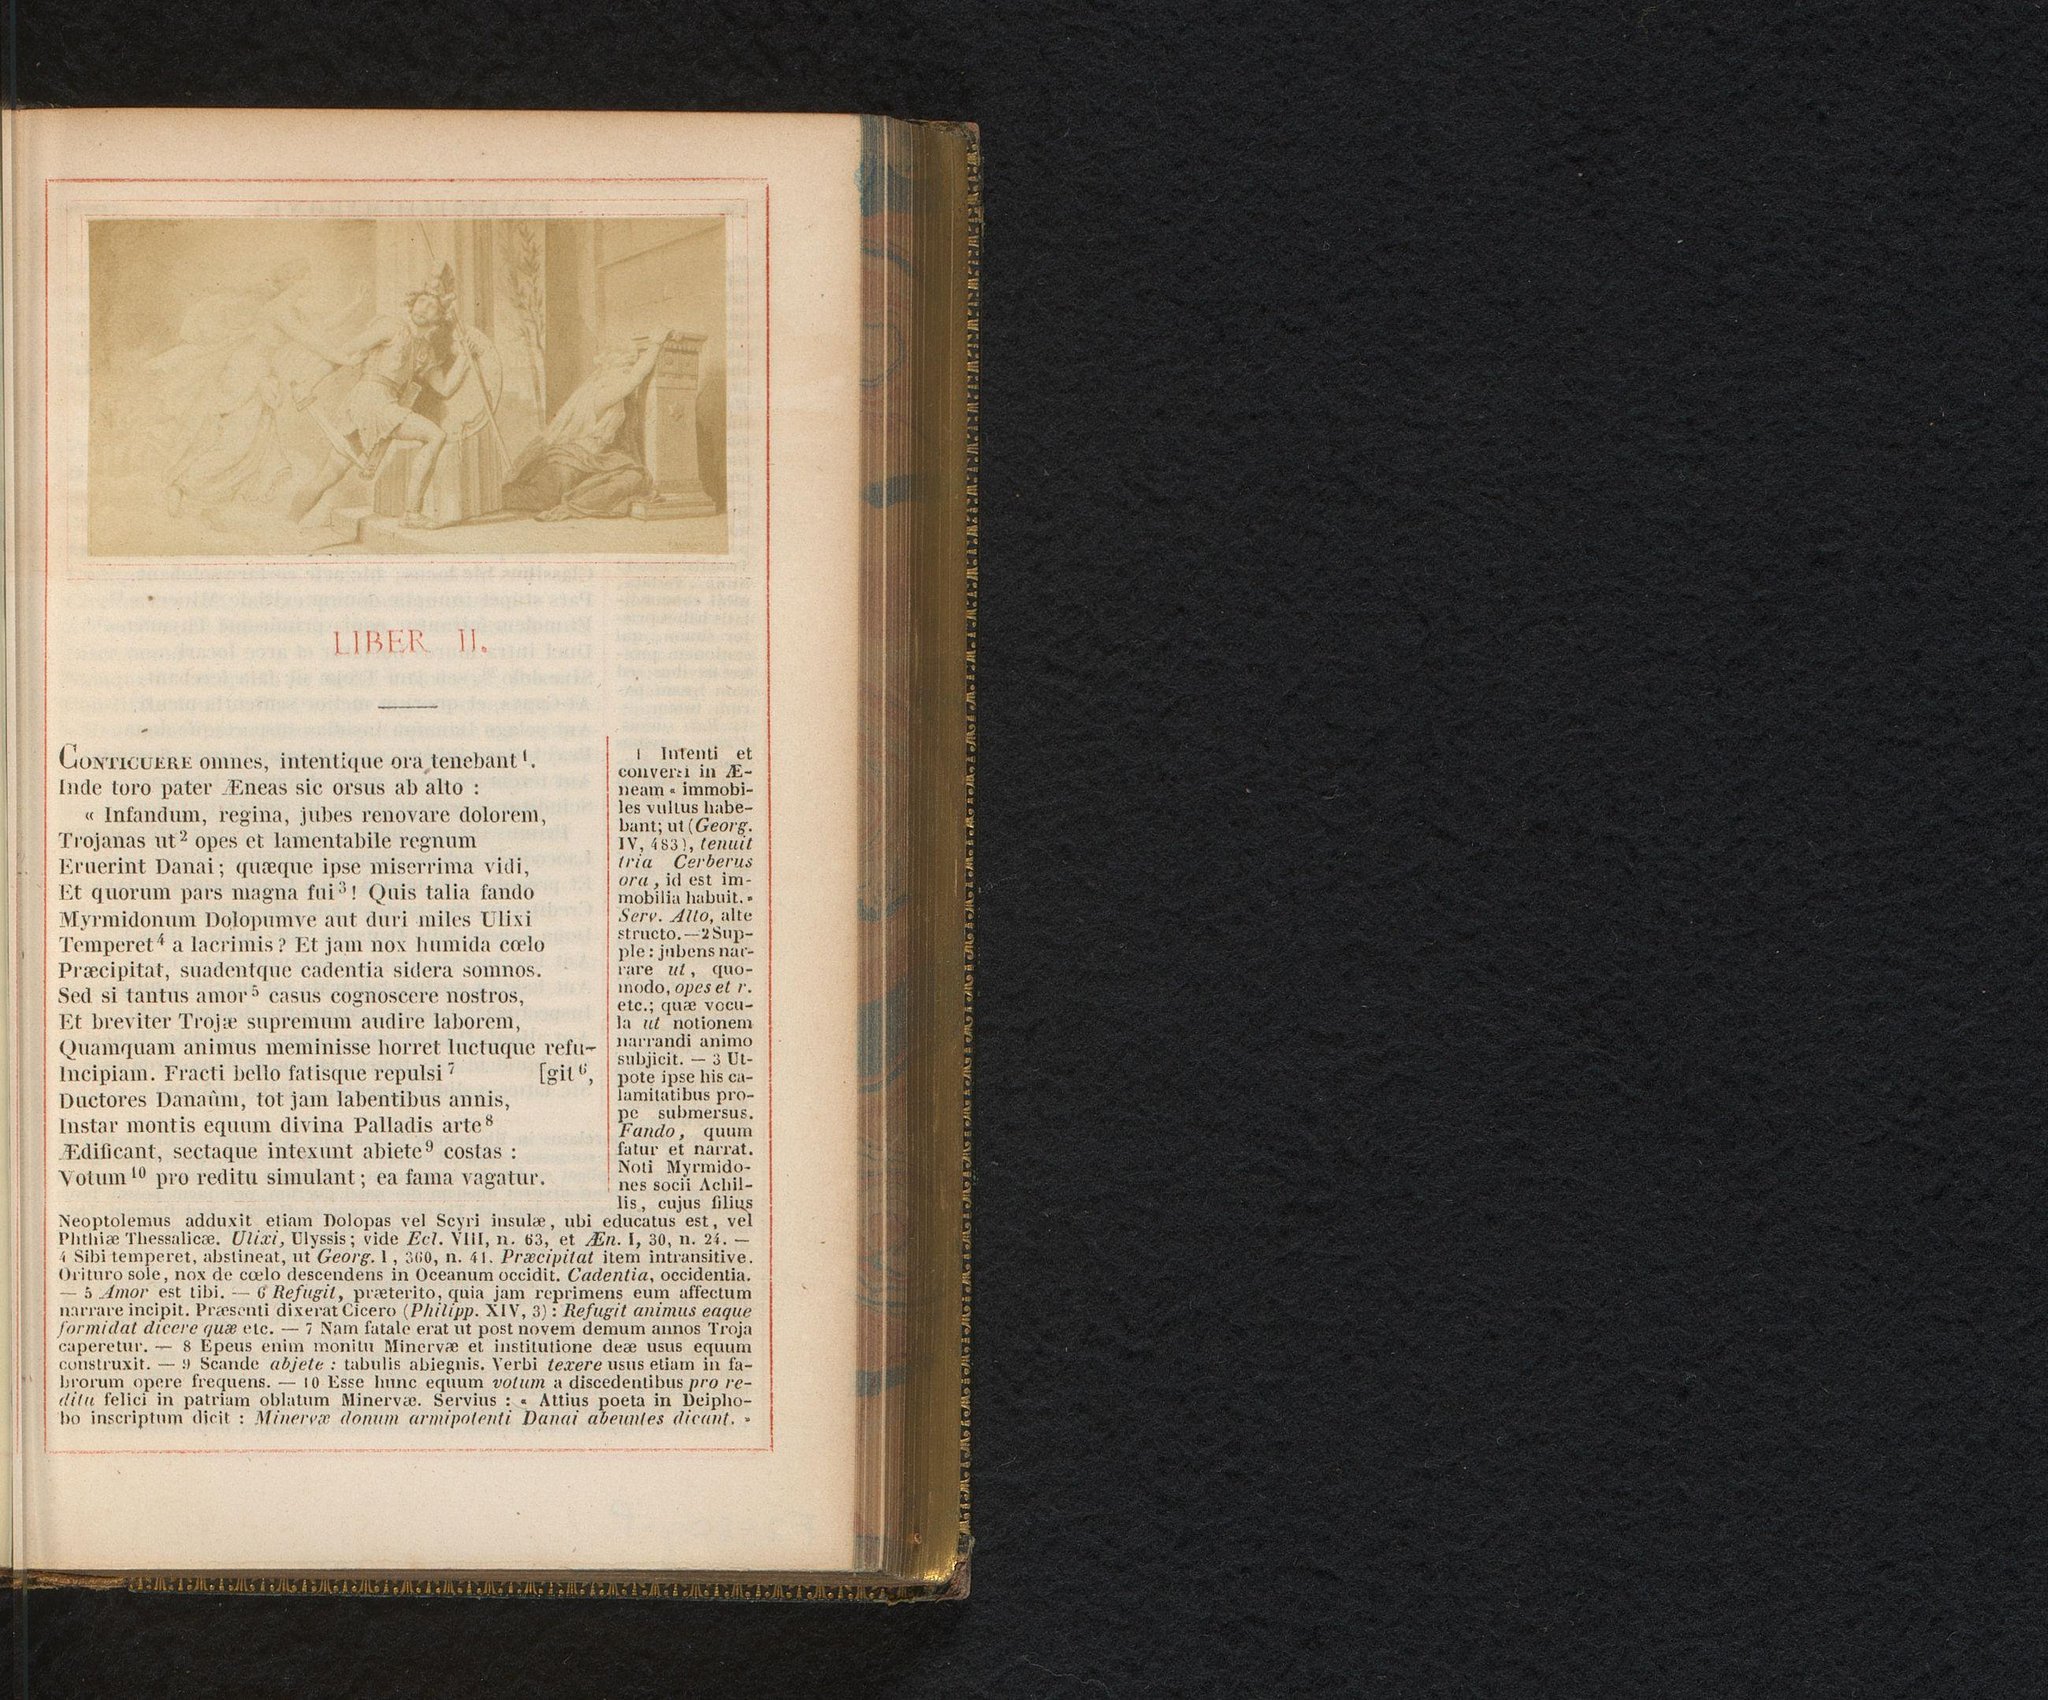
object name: page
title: Fotoreproductie van een schilderij, voorstellende Venus weerhoudt Aeneas van het doden van Helena, scène uit Virgilius' Aeneis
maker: Anonymous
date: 1853-1858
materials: paper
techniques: albumen print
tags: venus appears to aeneas, who is just about to kill helen, and advises him to flee